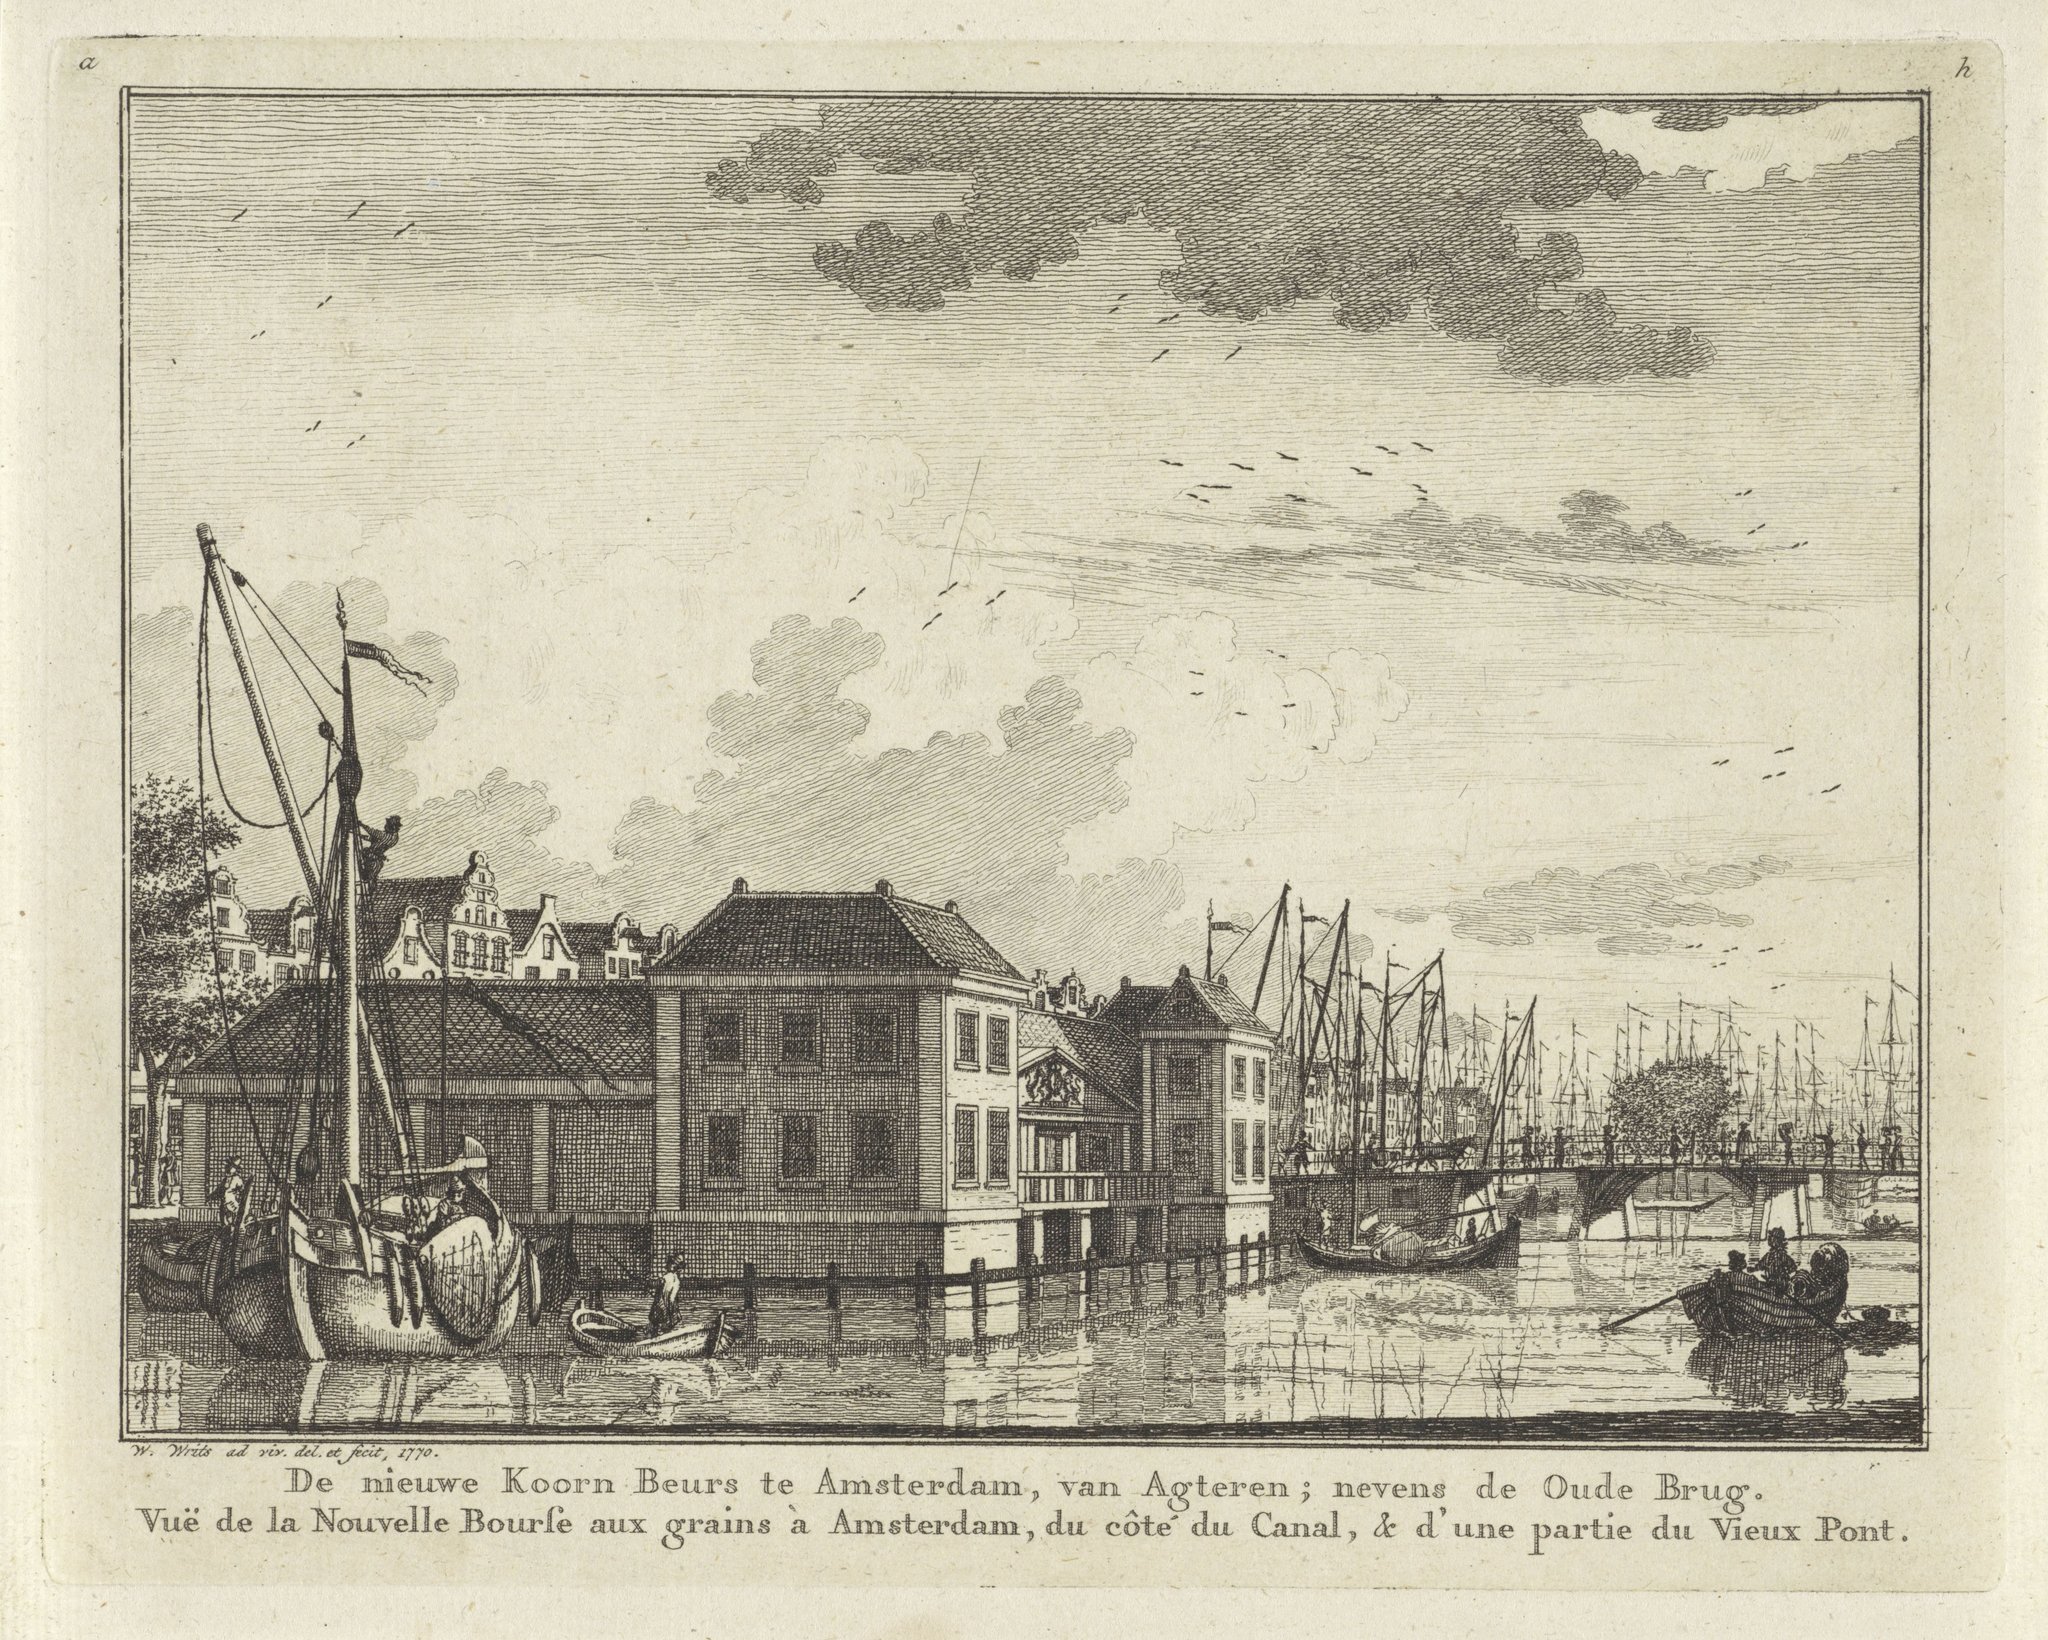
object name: print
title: Nieuwe Korenbeurs Amsterdam, vanaf het water gezien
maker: willem writs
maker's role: draughtsman, print maker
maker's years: 1731-1786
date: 1770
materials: paper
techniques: etching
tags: sailing-ship, sailing-boat, exchange, bourse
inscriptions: collector's mark: Lugt 2228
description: De prent werd eerst in 1770 uitgegeven door onder anderen Reinier Ottens en Pieter Yver, als onderdeel van een serie stadsgezichten: de 'Atlas van de stad Amsterdam; of Afbeelding der voornaamste gezichten, gebouwen, oudheeden en historien van Amsterdam (...)'. Deze serie, begonnen in 1769, bevatte prenten met tekstuele toelichting die konden worden ingebonden in verschillende publicaties over Amsterdam. De prent werd ook nog gebruikt in: Atlas van de waereldberoemde koopstad Amsteldam (...). Amsterdam: Jan Barend Elwe, 1804. Latere staat, genummerd rechtsboven met pl. 2, gebruikt in publicatie uit 1824.